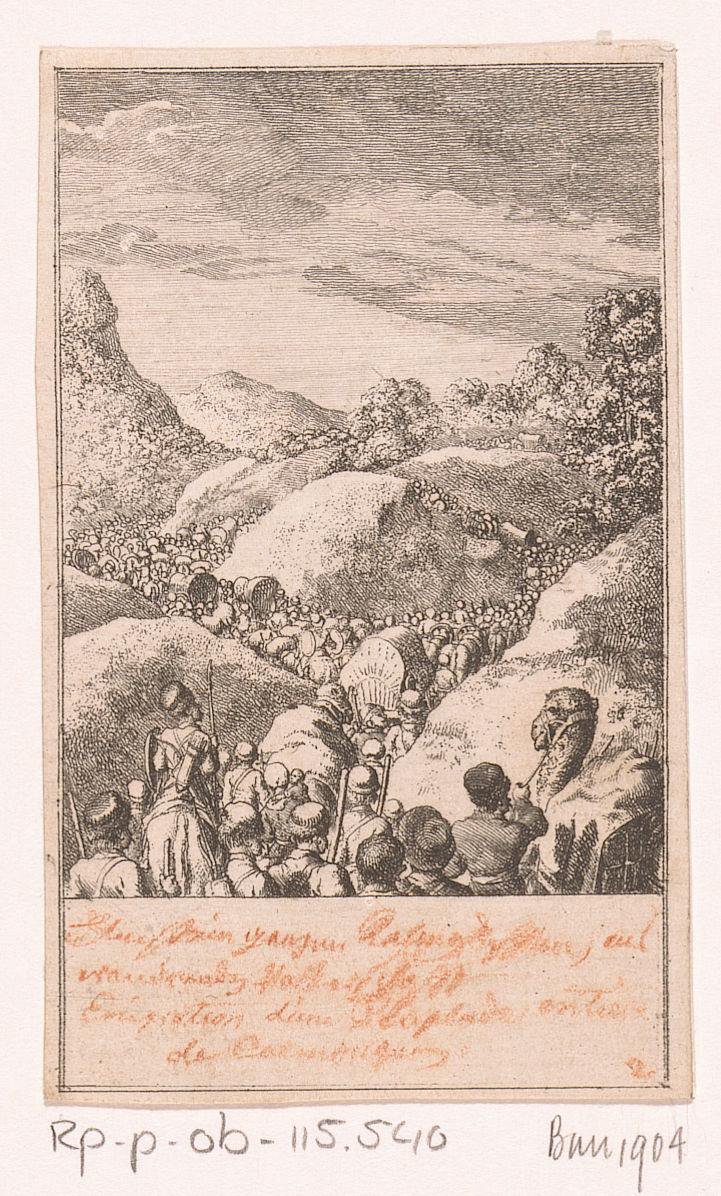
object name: print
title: Vluchtende Kalmukken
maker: daniel nikolaus chodowiecki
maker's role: draughtsman, print maker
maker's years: 1726-1801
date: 1797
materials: paper, pencil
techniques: etching, writing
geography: berlin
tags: catharina de grote, landscapes, history, political refugee, 'émigré'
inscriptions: collector's mark: Lugt 2228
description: Latere staat gebruikt voor: Historisch-genealogischer Kalender auf das Gemeinjahr 1798. Katharina II. Ein historischer Versuch (...). Berlijn: Johann Friedrich Unger, [1797].